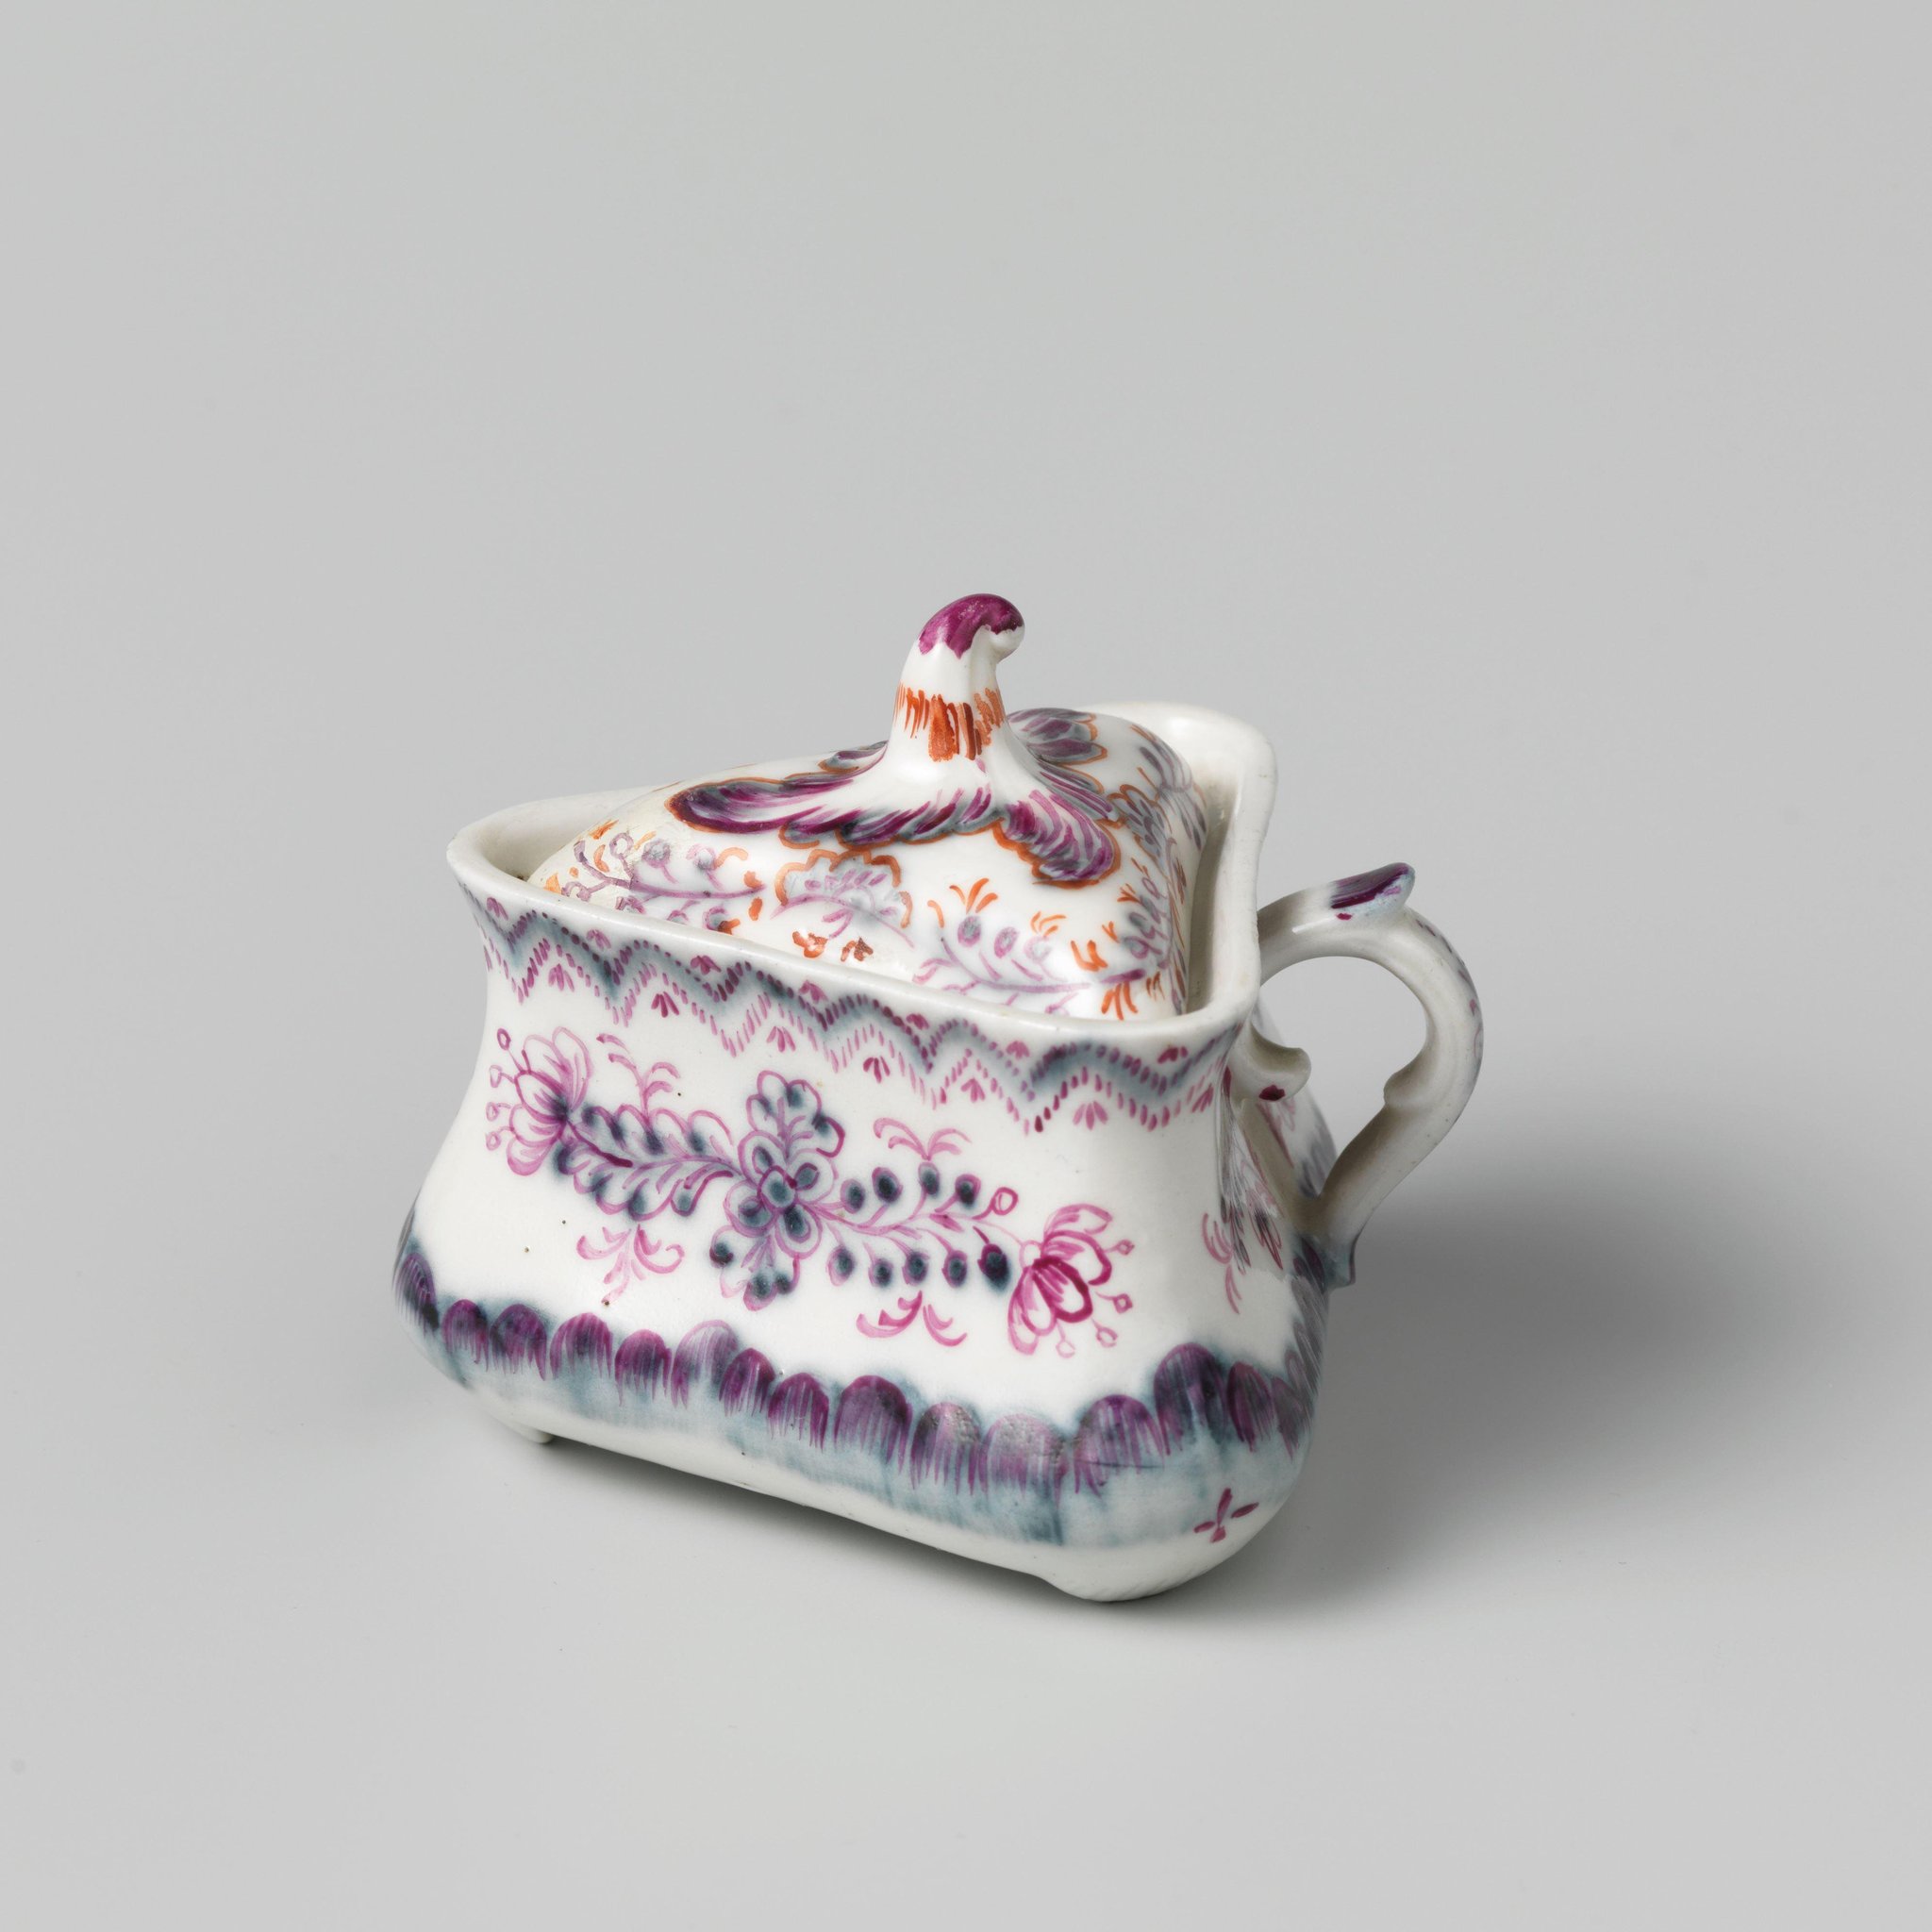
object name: roompot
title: Deksel van roompot, beschilderd met bloem- en bladtakken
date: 1774-1778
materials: porcelain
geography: loosdrecht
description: Deksel van porselein. Driehoekig met vraagtekenvormig oor en ingesnoerde wand. Beschilderd in onderglazuurblauw en paars (het dekseltje ook nog in rood) met bloem- en bladtakken en ornament langs de randen (alleen aan de voetrand in licht reliëf).